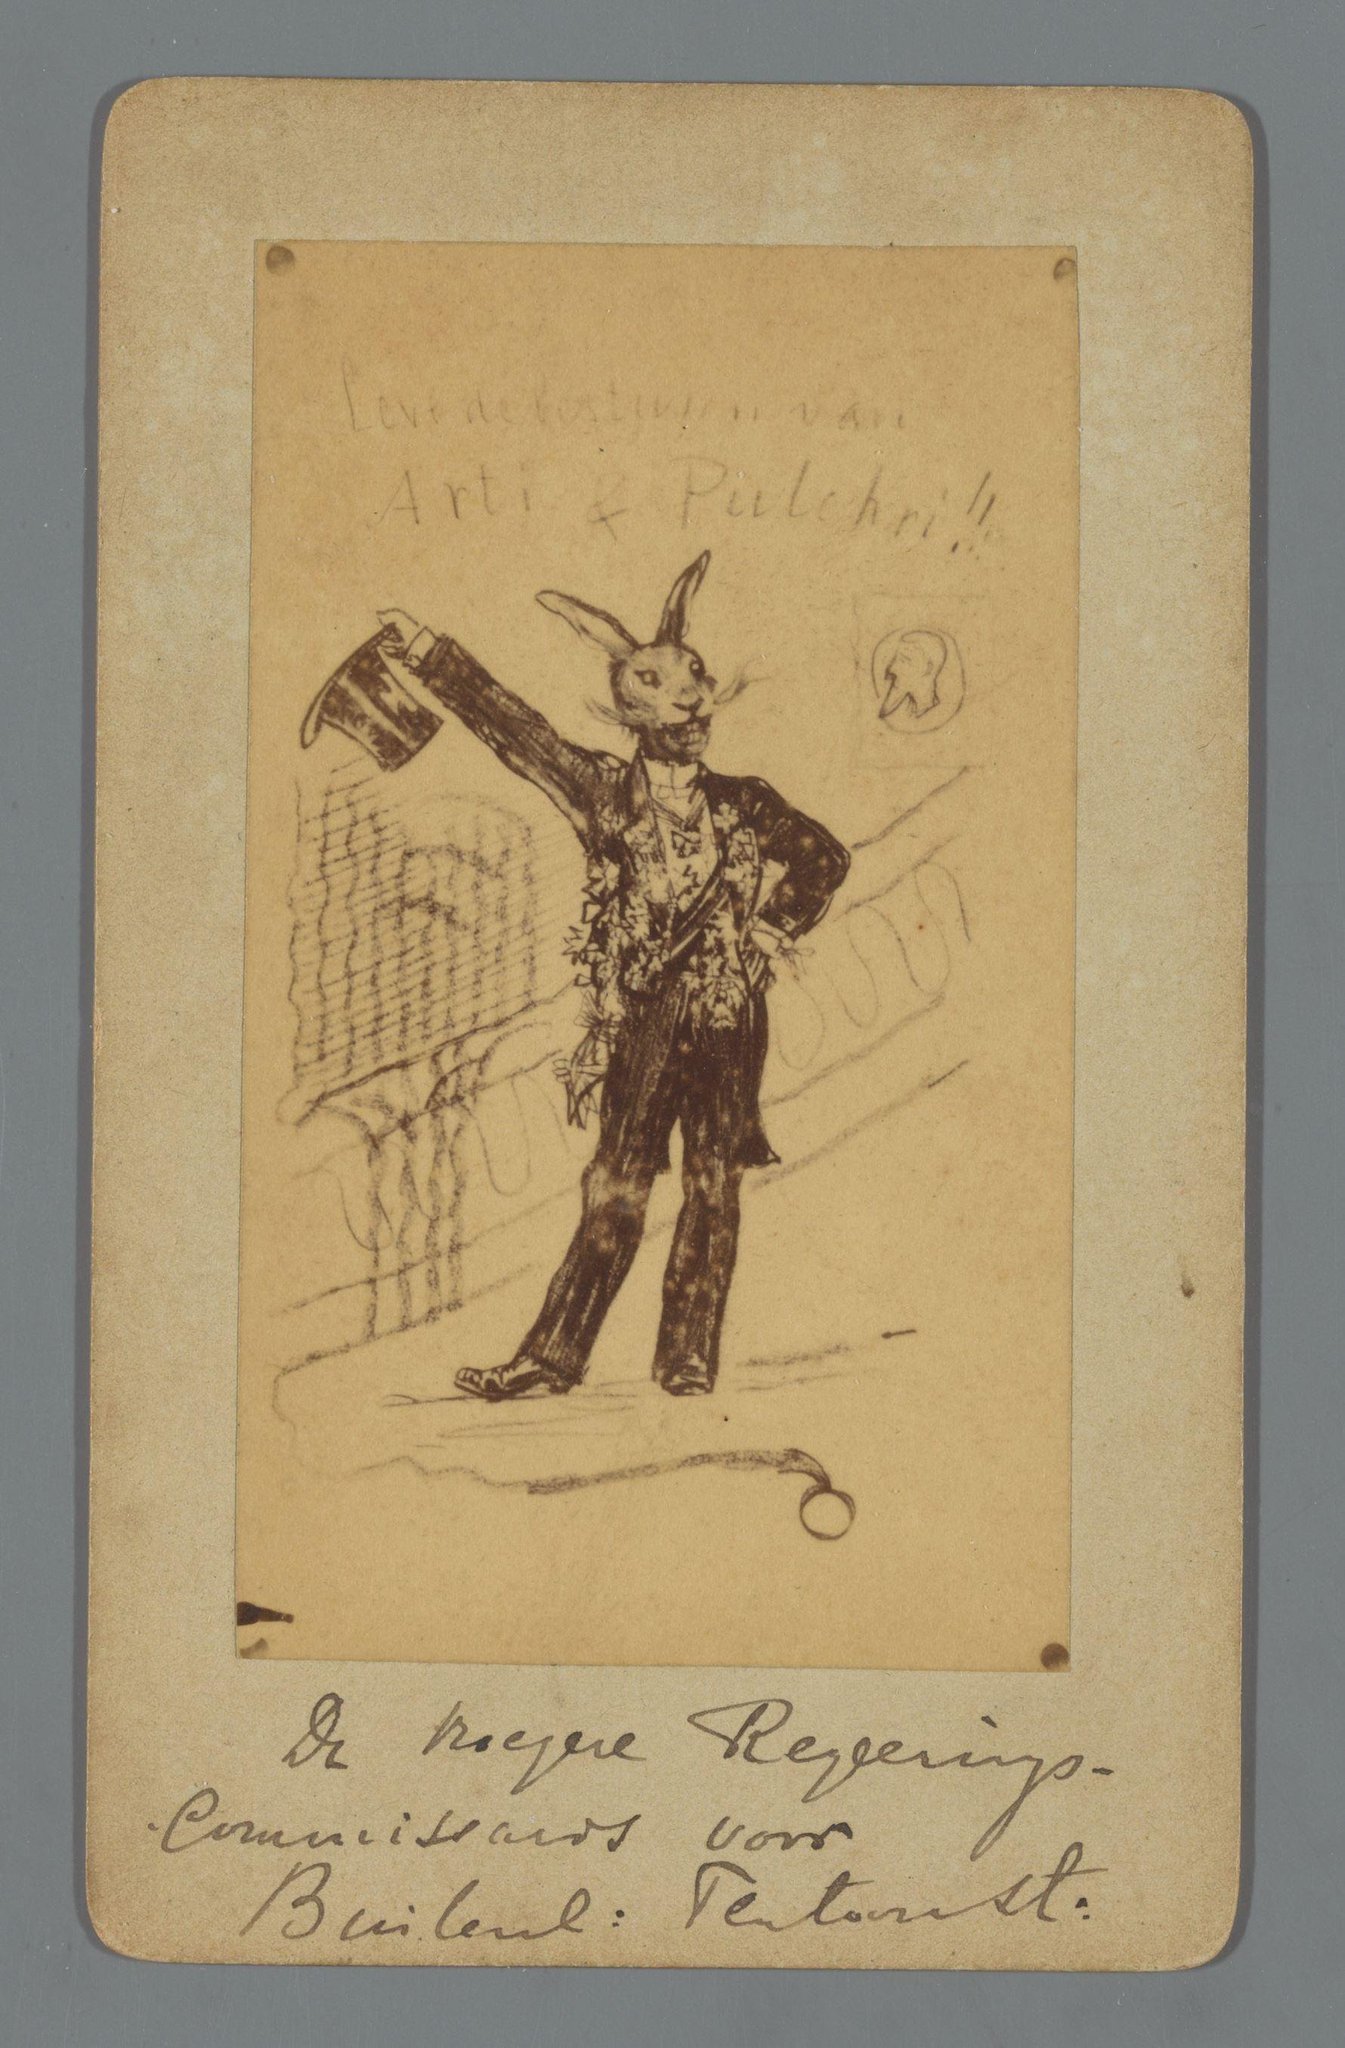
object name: photograph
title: Fotomontage: karikatuur van de "vroegere regeringscommissaris voor buitenlandse tentoonstellingen", met het opschrift "Lefe de besturen van Arti & Pulchri!!" (Arti, Pulchri Studio)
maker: machiel hendricus laddé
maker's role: fotograaf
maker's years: 1866-1932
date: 1890-1900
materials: cardboard, photographic support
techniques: albumen print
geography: amsterdam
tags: animals acting as human beings, rodents: rabbit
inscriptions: : ‘MHL / M.H. Laddé / AMSTERDAM’, annotation: ‘De vroegere Regeerings- / Commissaris voor / Buitenl: Tentoonst:’